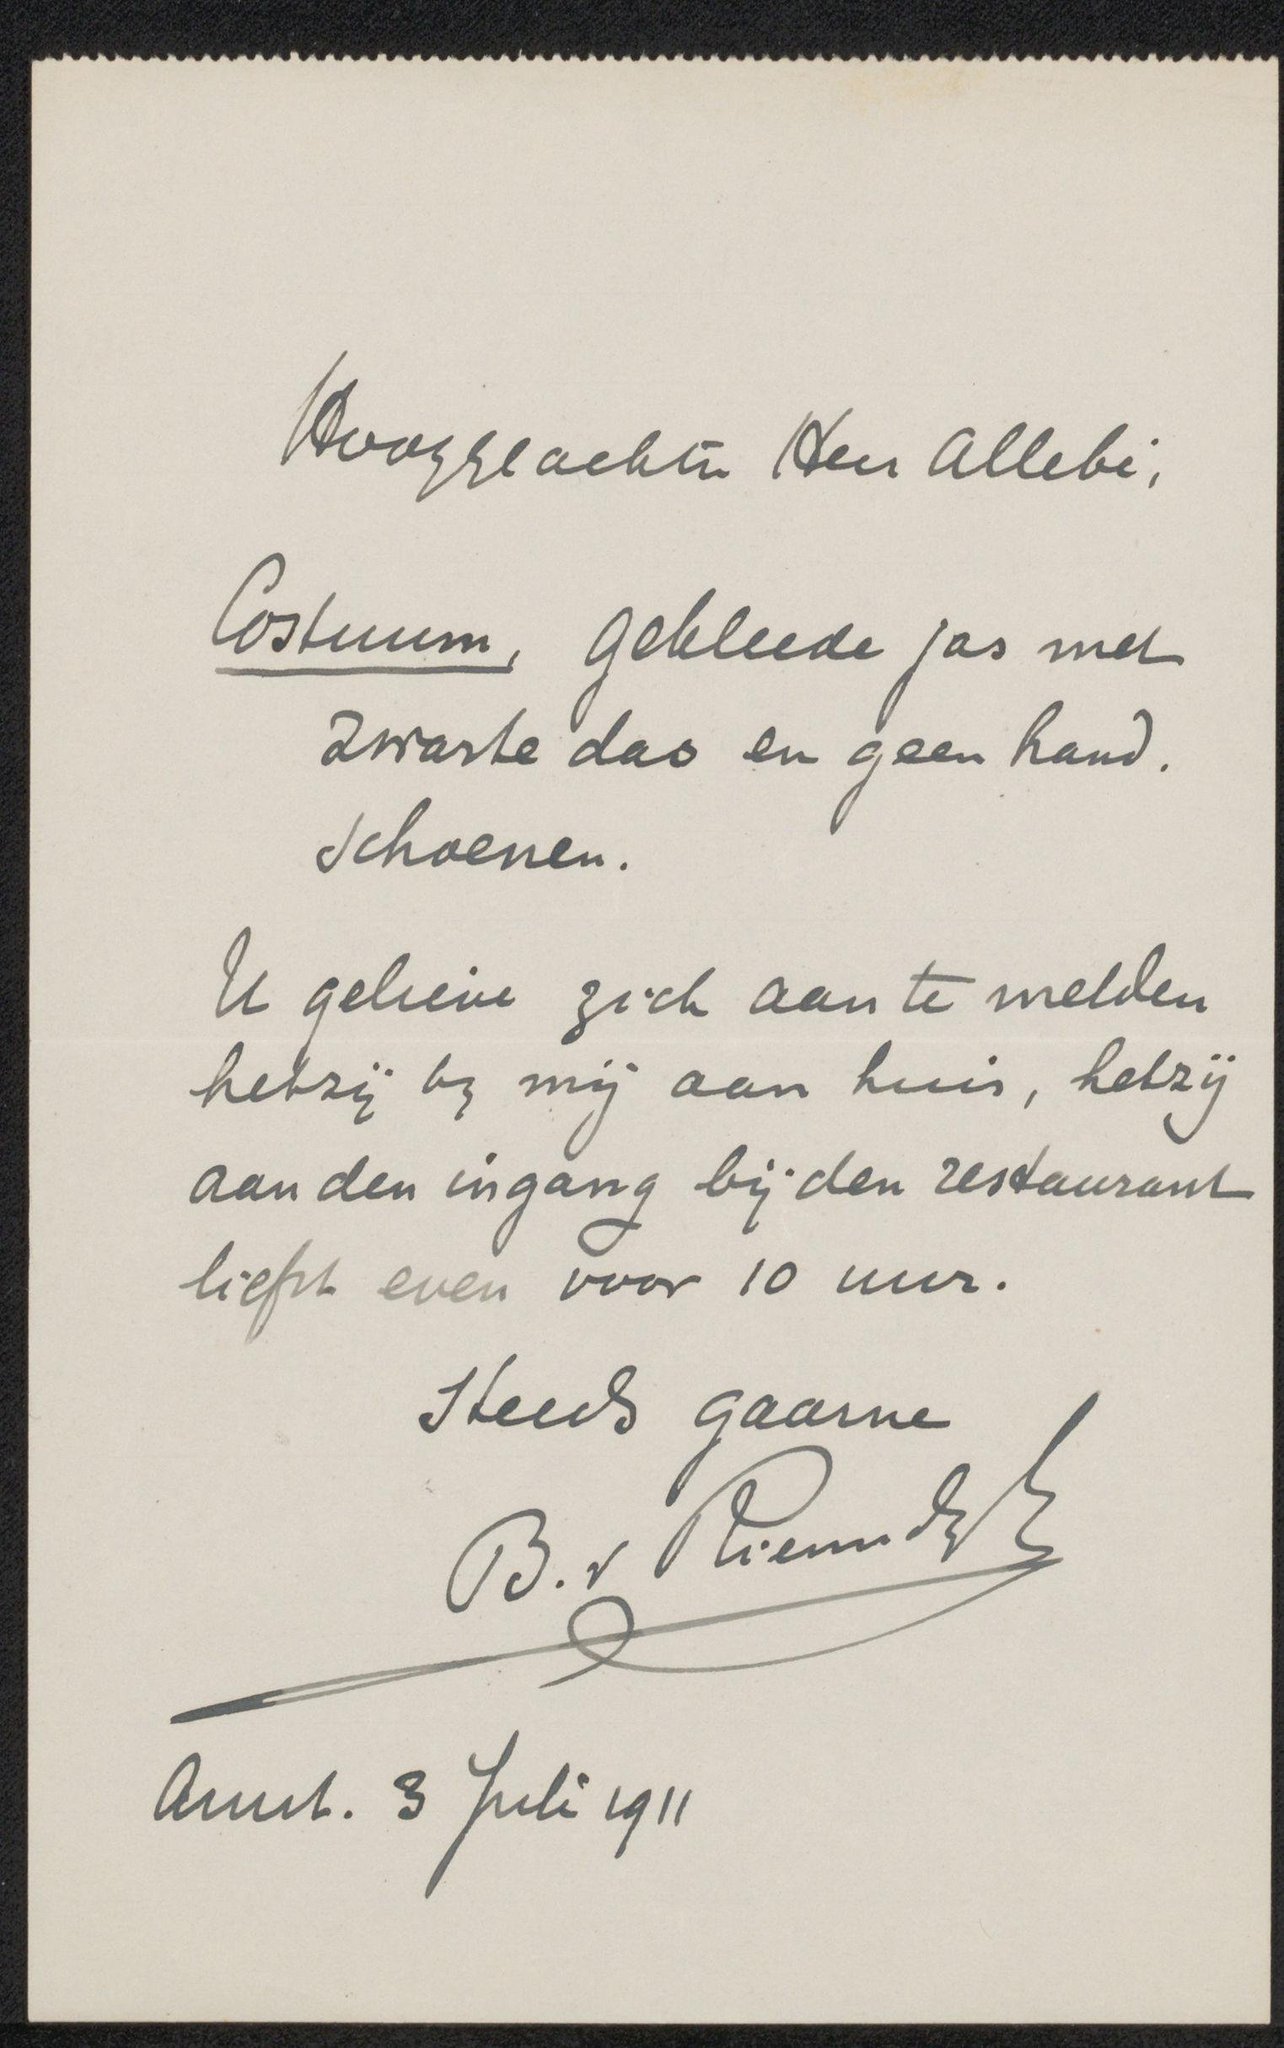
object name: letter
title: Brief aan August Allebé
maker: jonkheer barthold willem floris van riemsdijk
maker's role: engineer, print maker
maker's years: 1850-1942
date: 1911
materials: ink, paper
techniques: pen, writing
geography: amsterdam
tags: amsterdam, print maker, draughtsman, august allebé